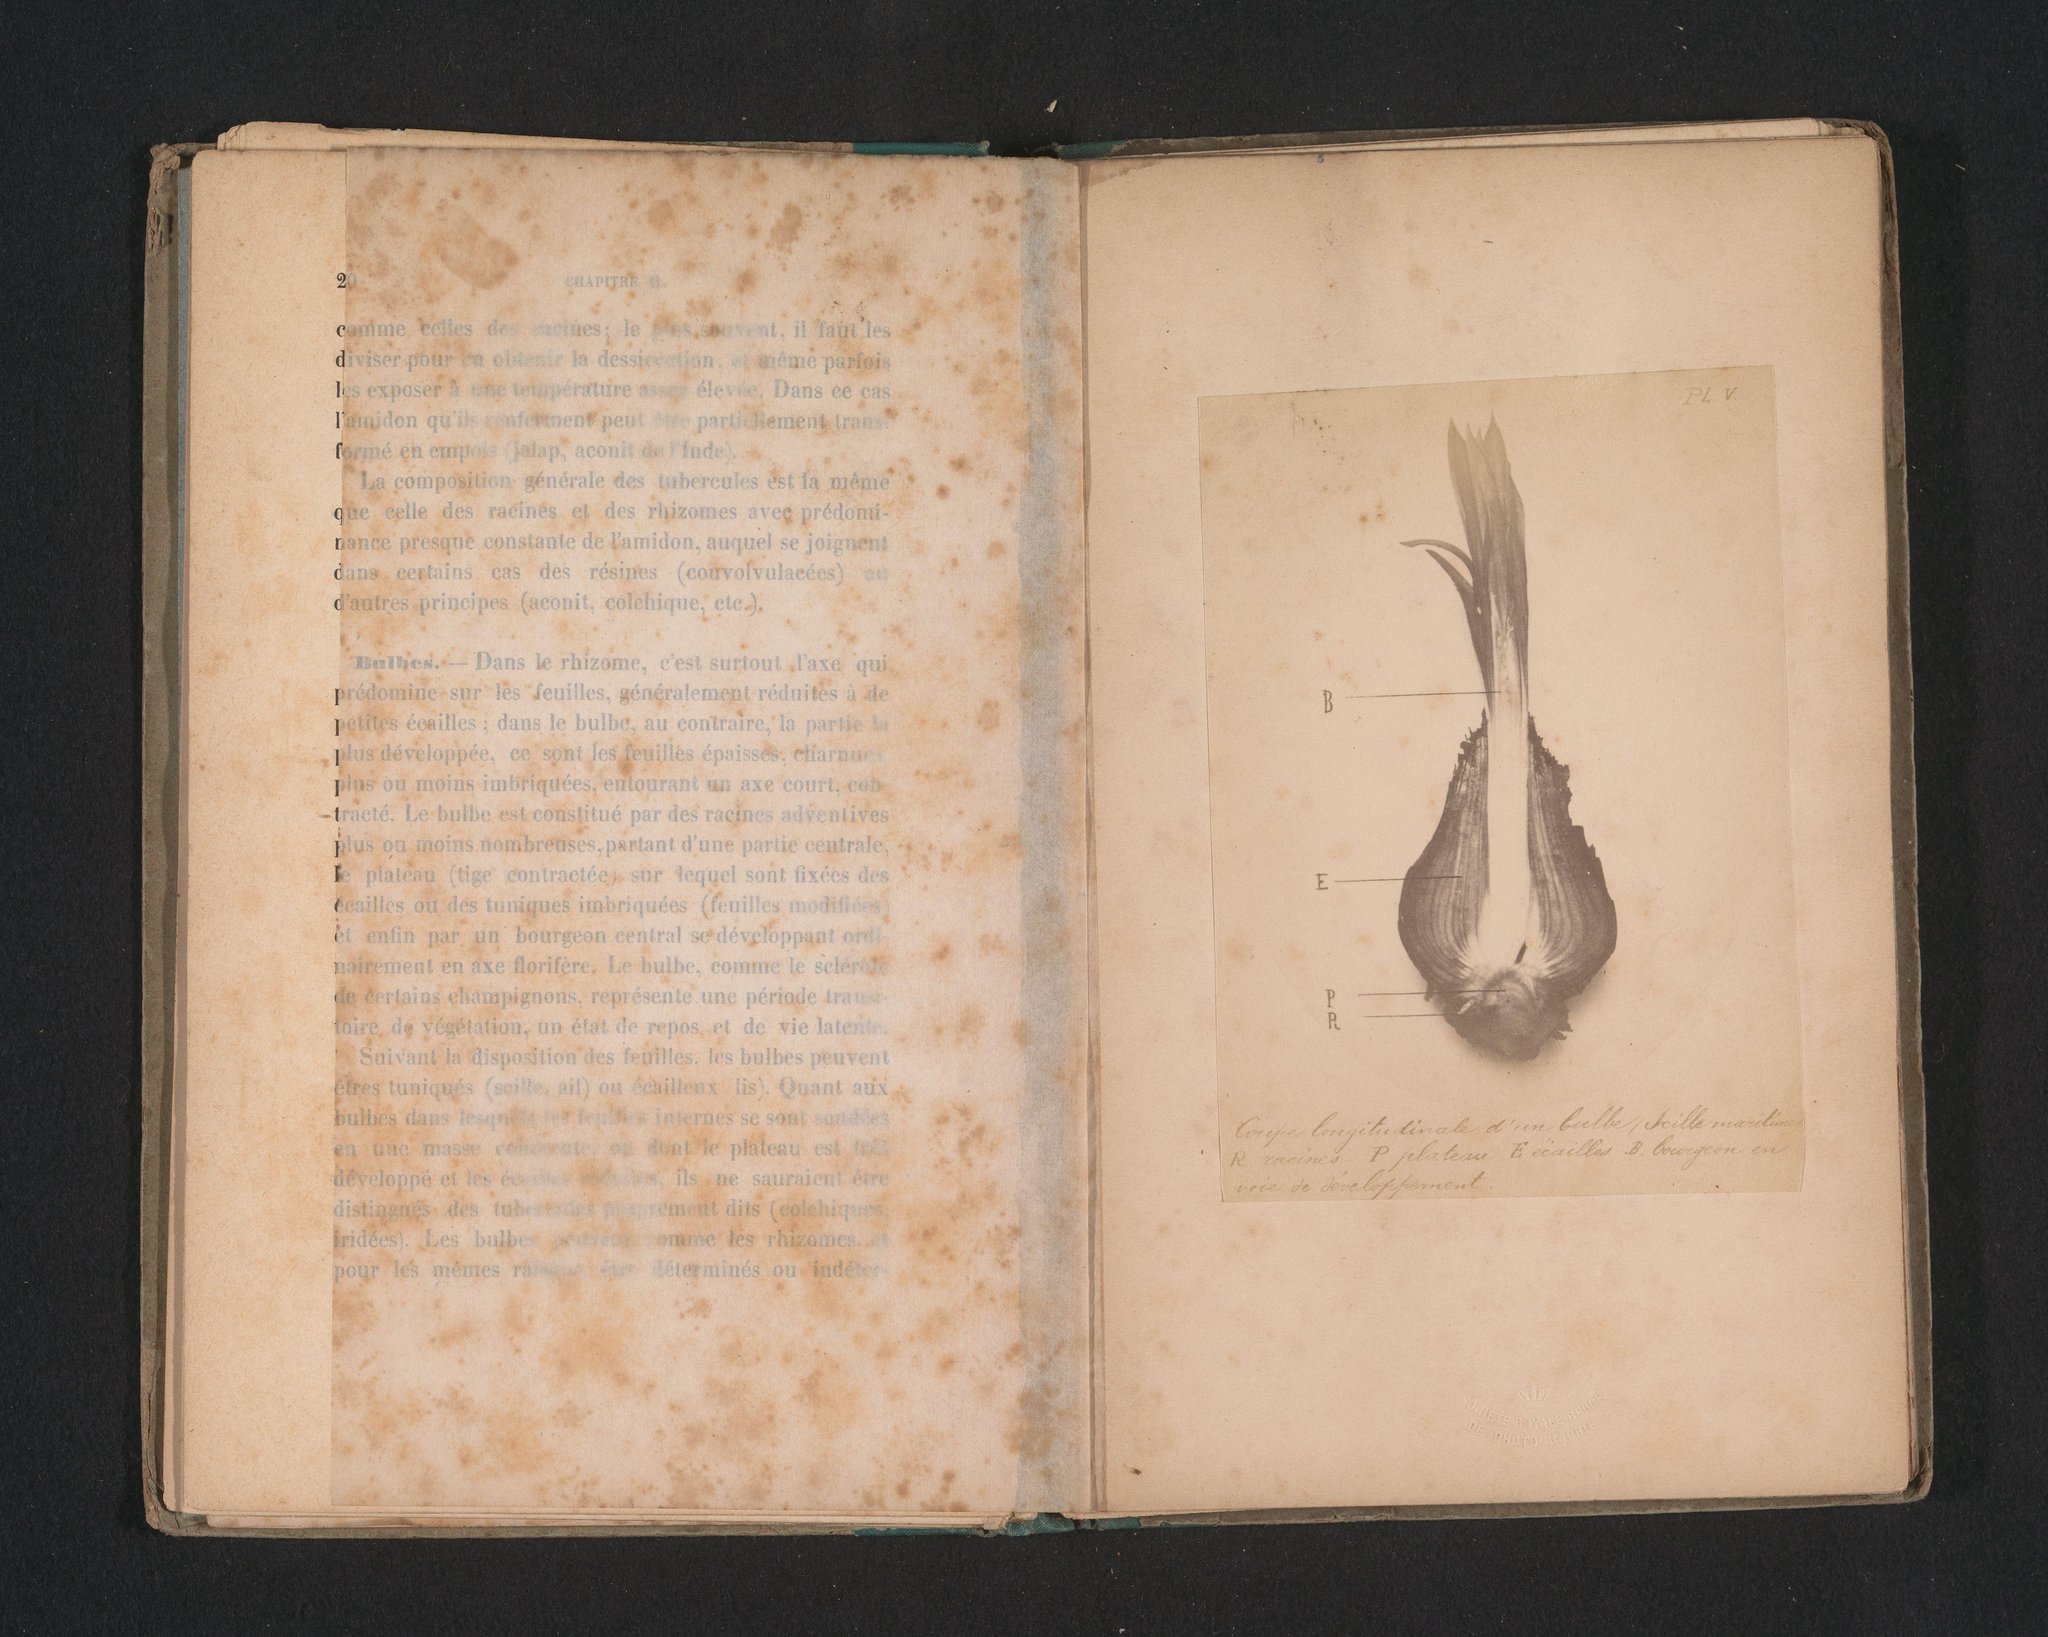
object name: page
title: Doornsede van een bloembol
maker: Anonymous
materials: photographic support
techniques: albumen print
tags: plants; vegetation